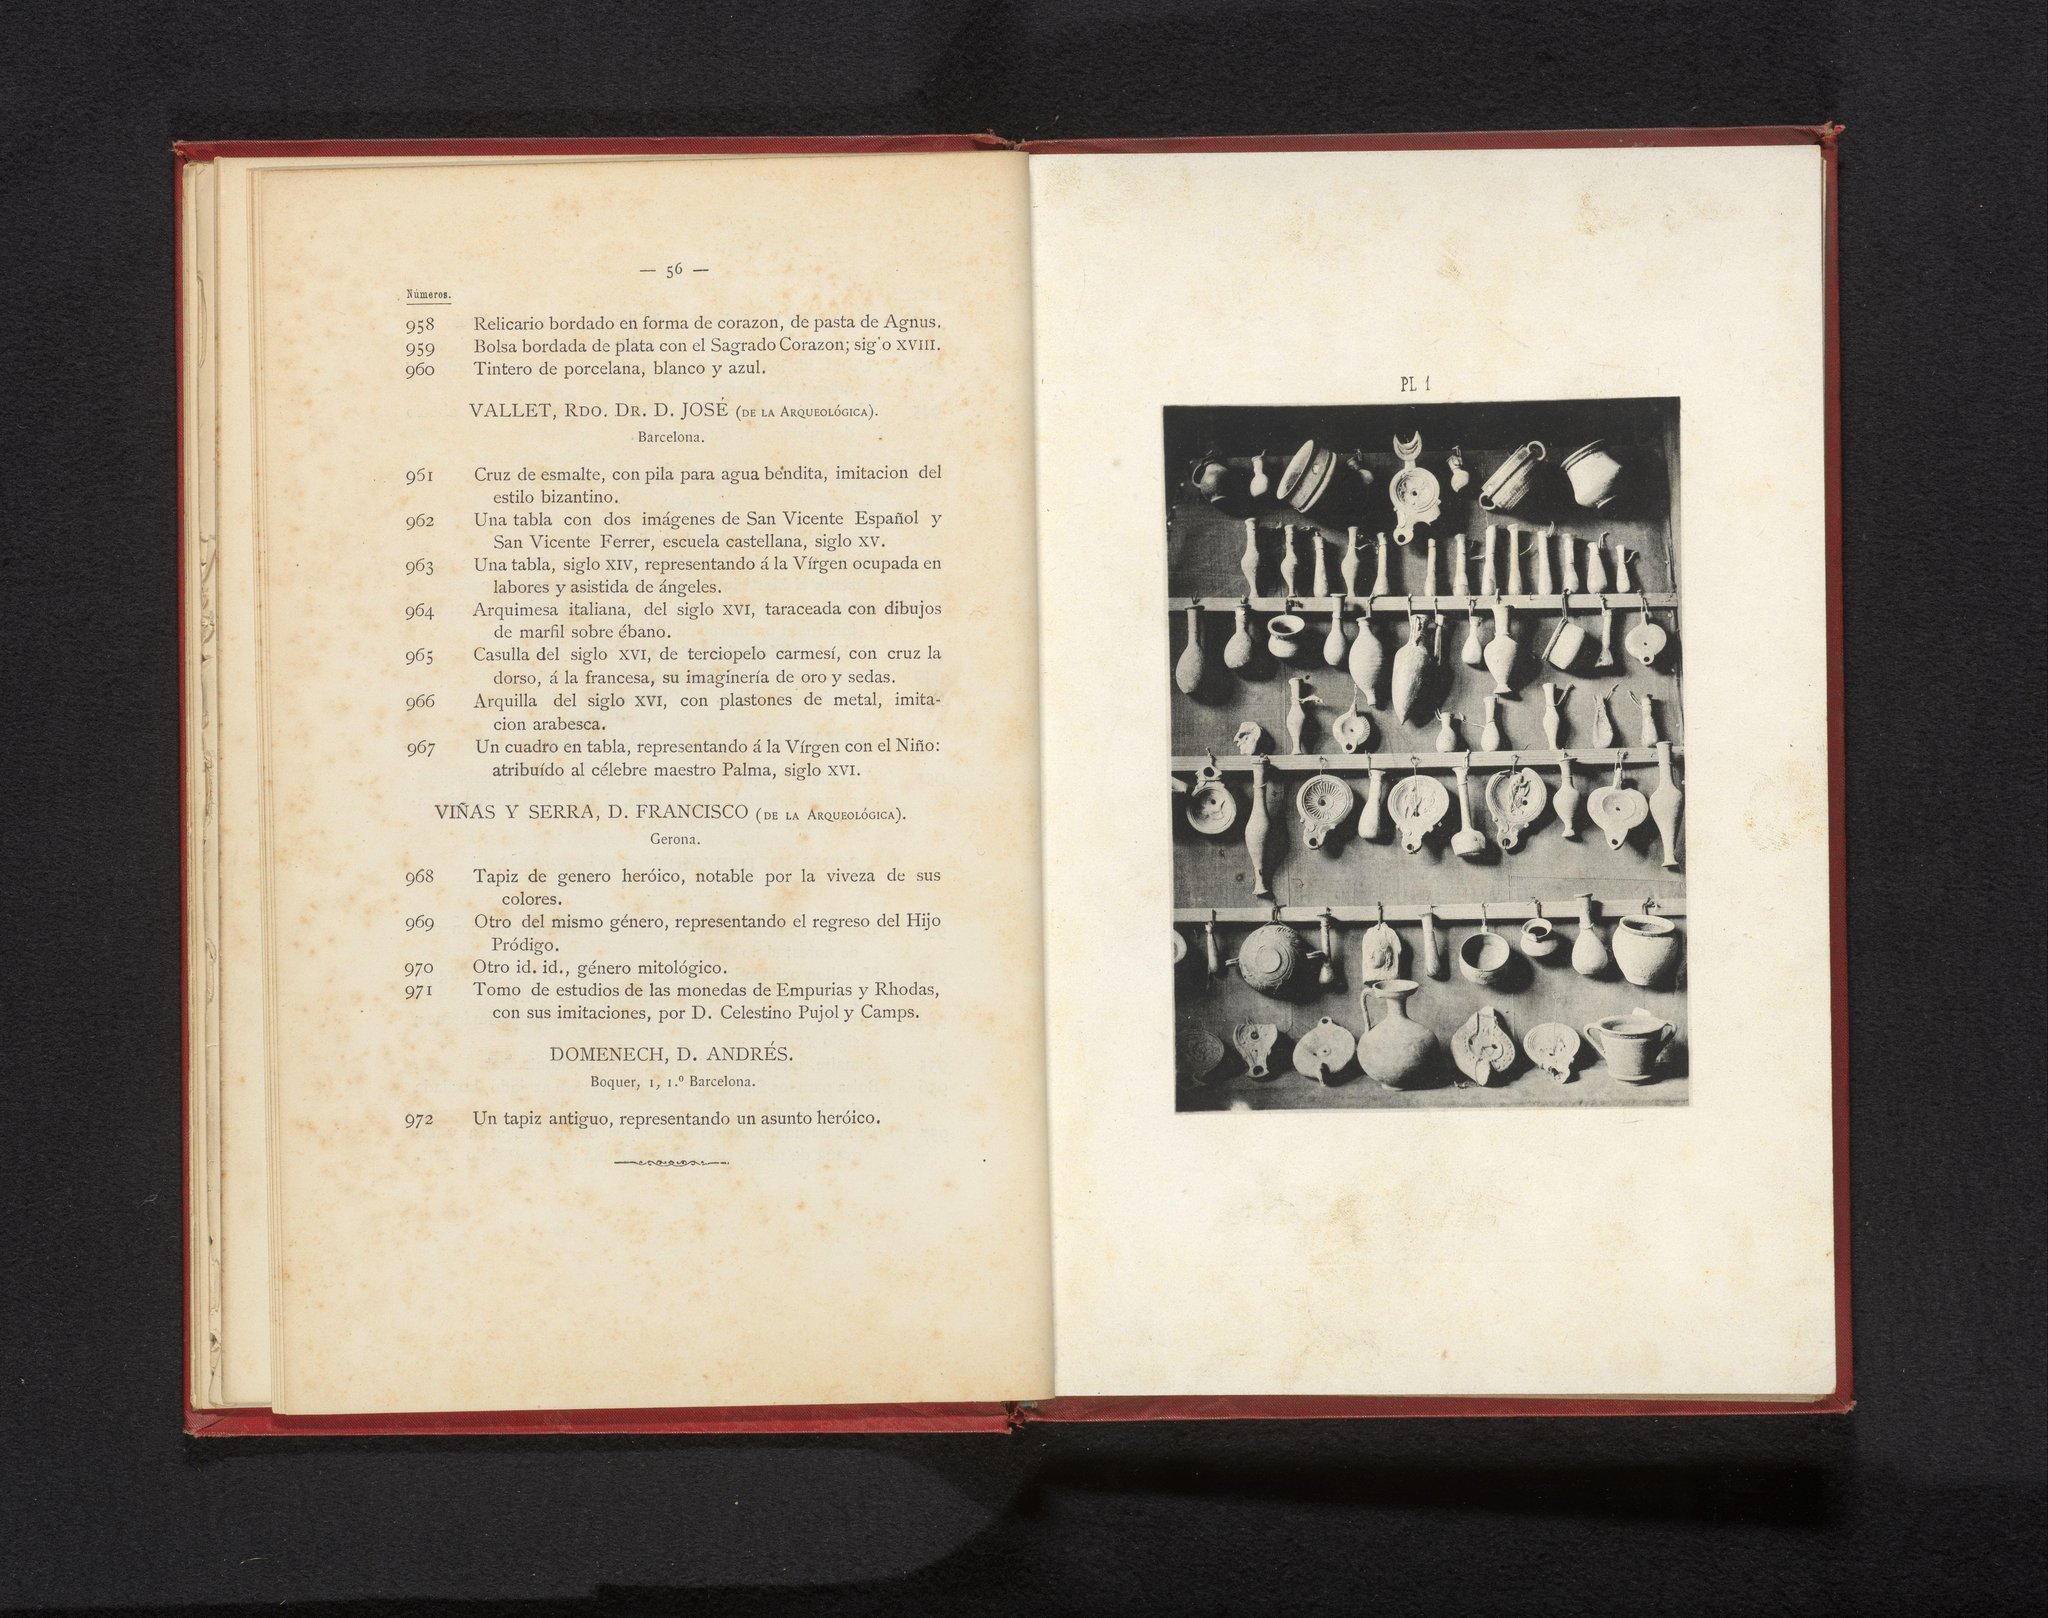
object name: photomechanical print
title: Uitstalling van aardewerken gebruiksvoorwerpen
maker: Anonymous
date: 1880-1881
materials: paper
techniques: photograph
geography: barcelona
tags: container of ceramics: jar, jug, pot, vase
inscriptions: number: ‘Pl 1’